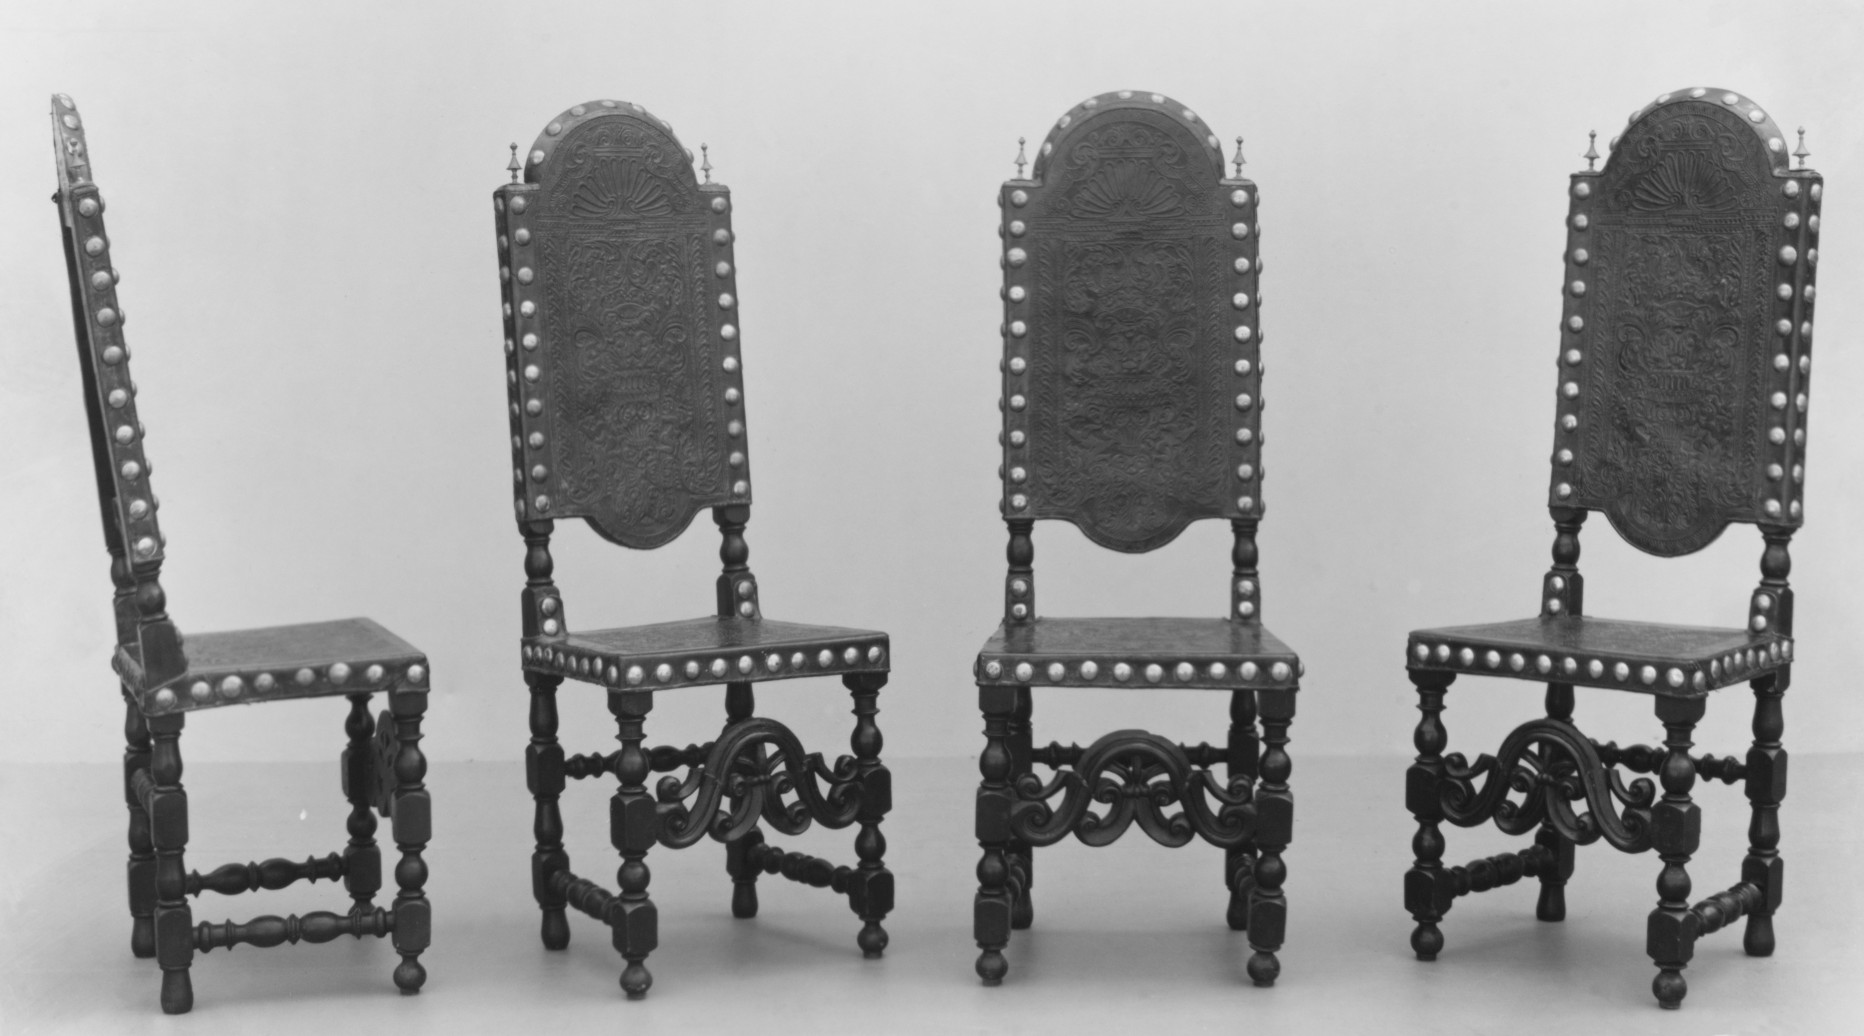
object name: chair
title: Pair of chairs (part of a set)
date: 1601-1700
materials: wood